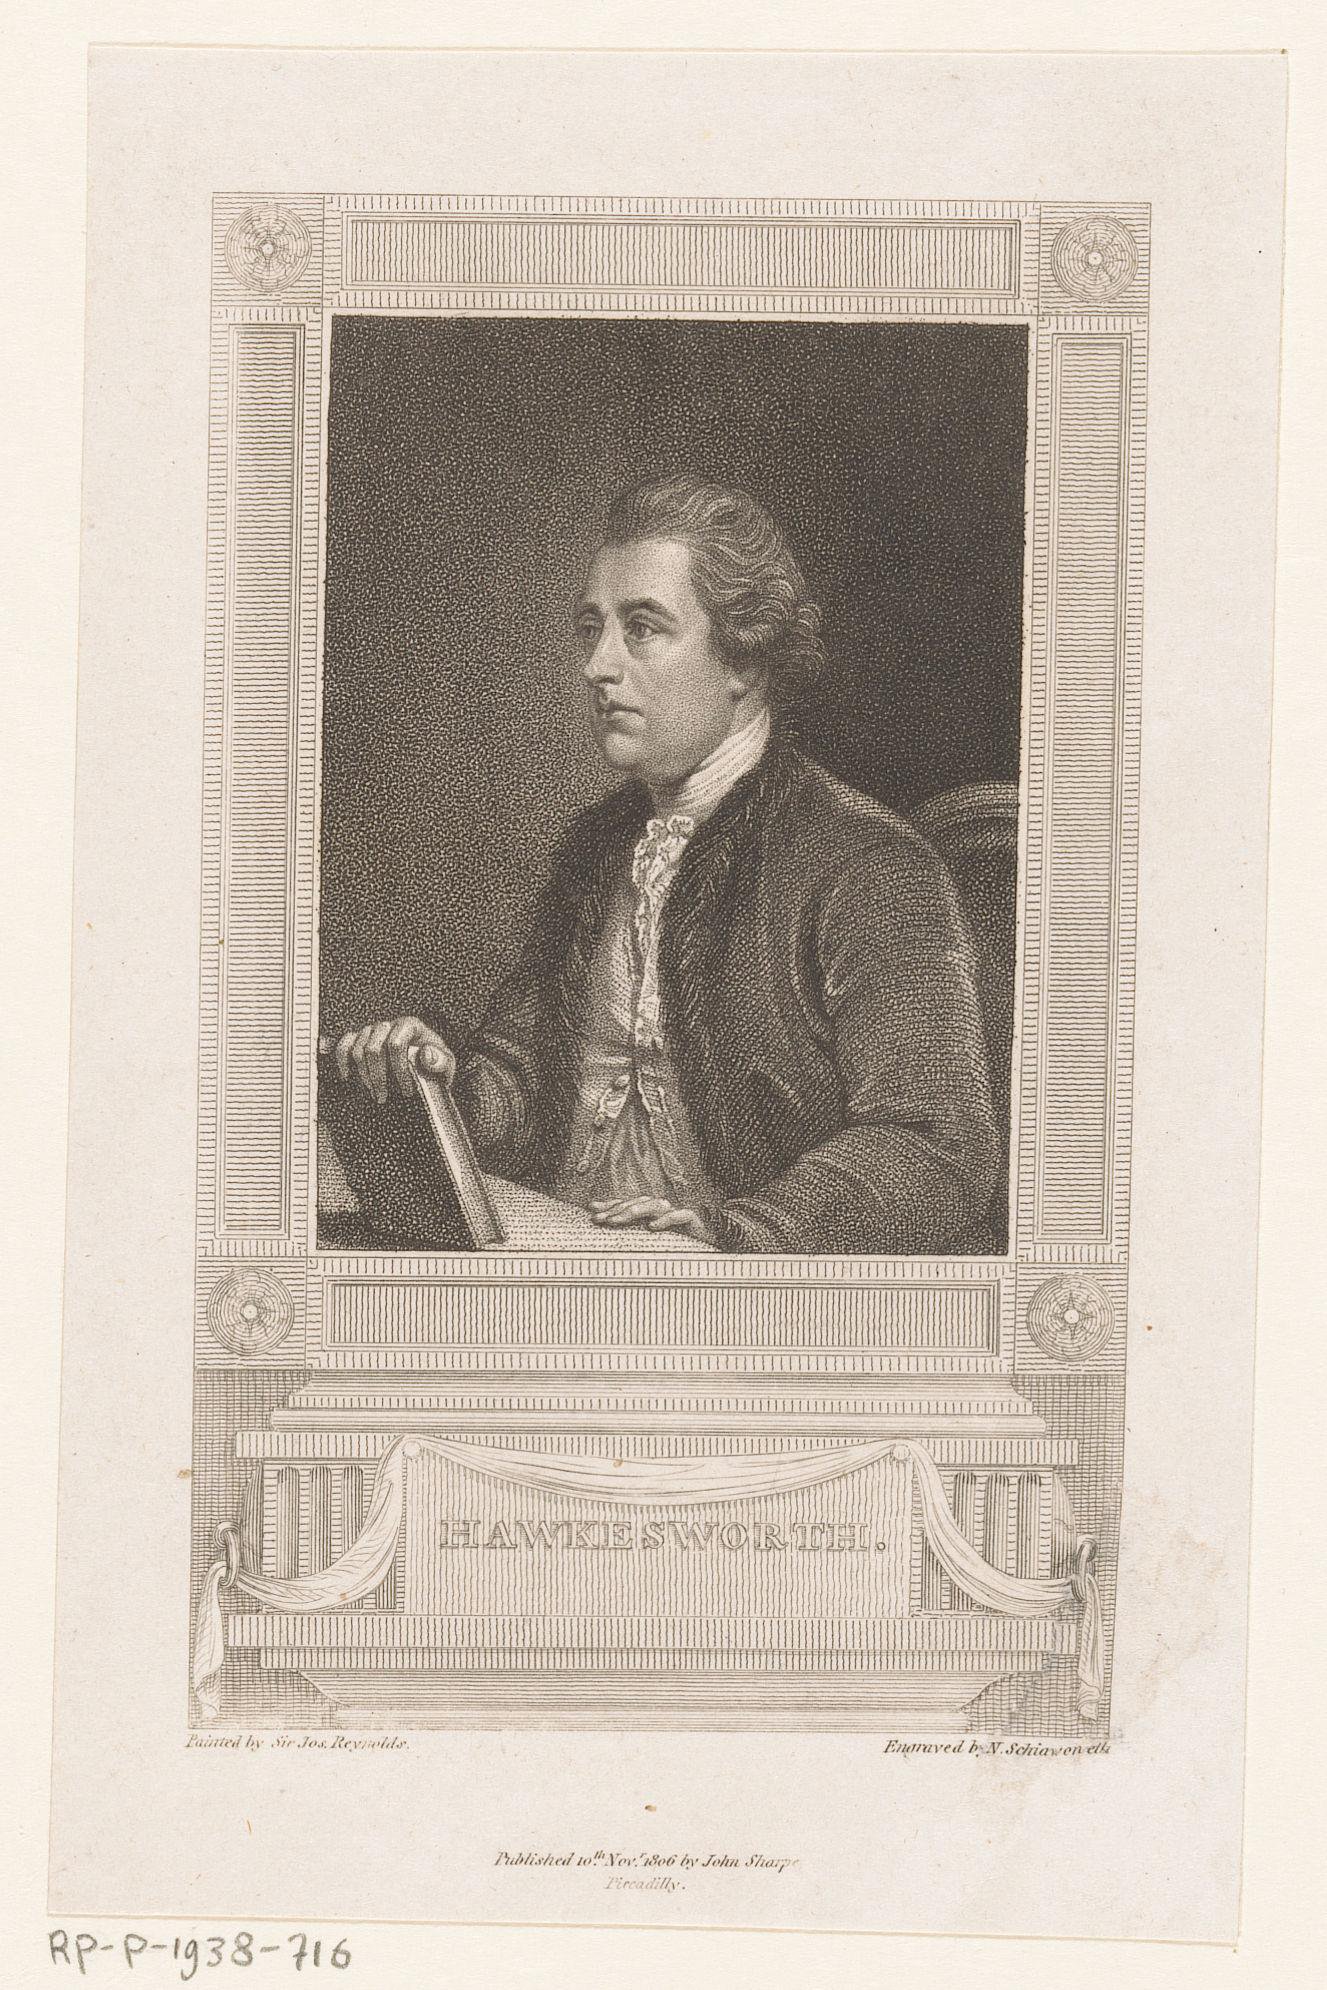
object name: print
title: Portret van schrijver John Hawkesworth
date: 1806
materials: paper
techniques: engraving, etching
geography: london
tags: historical persons, portrait of a writer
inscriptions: collector's mark: Lugt 2228